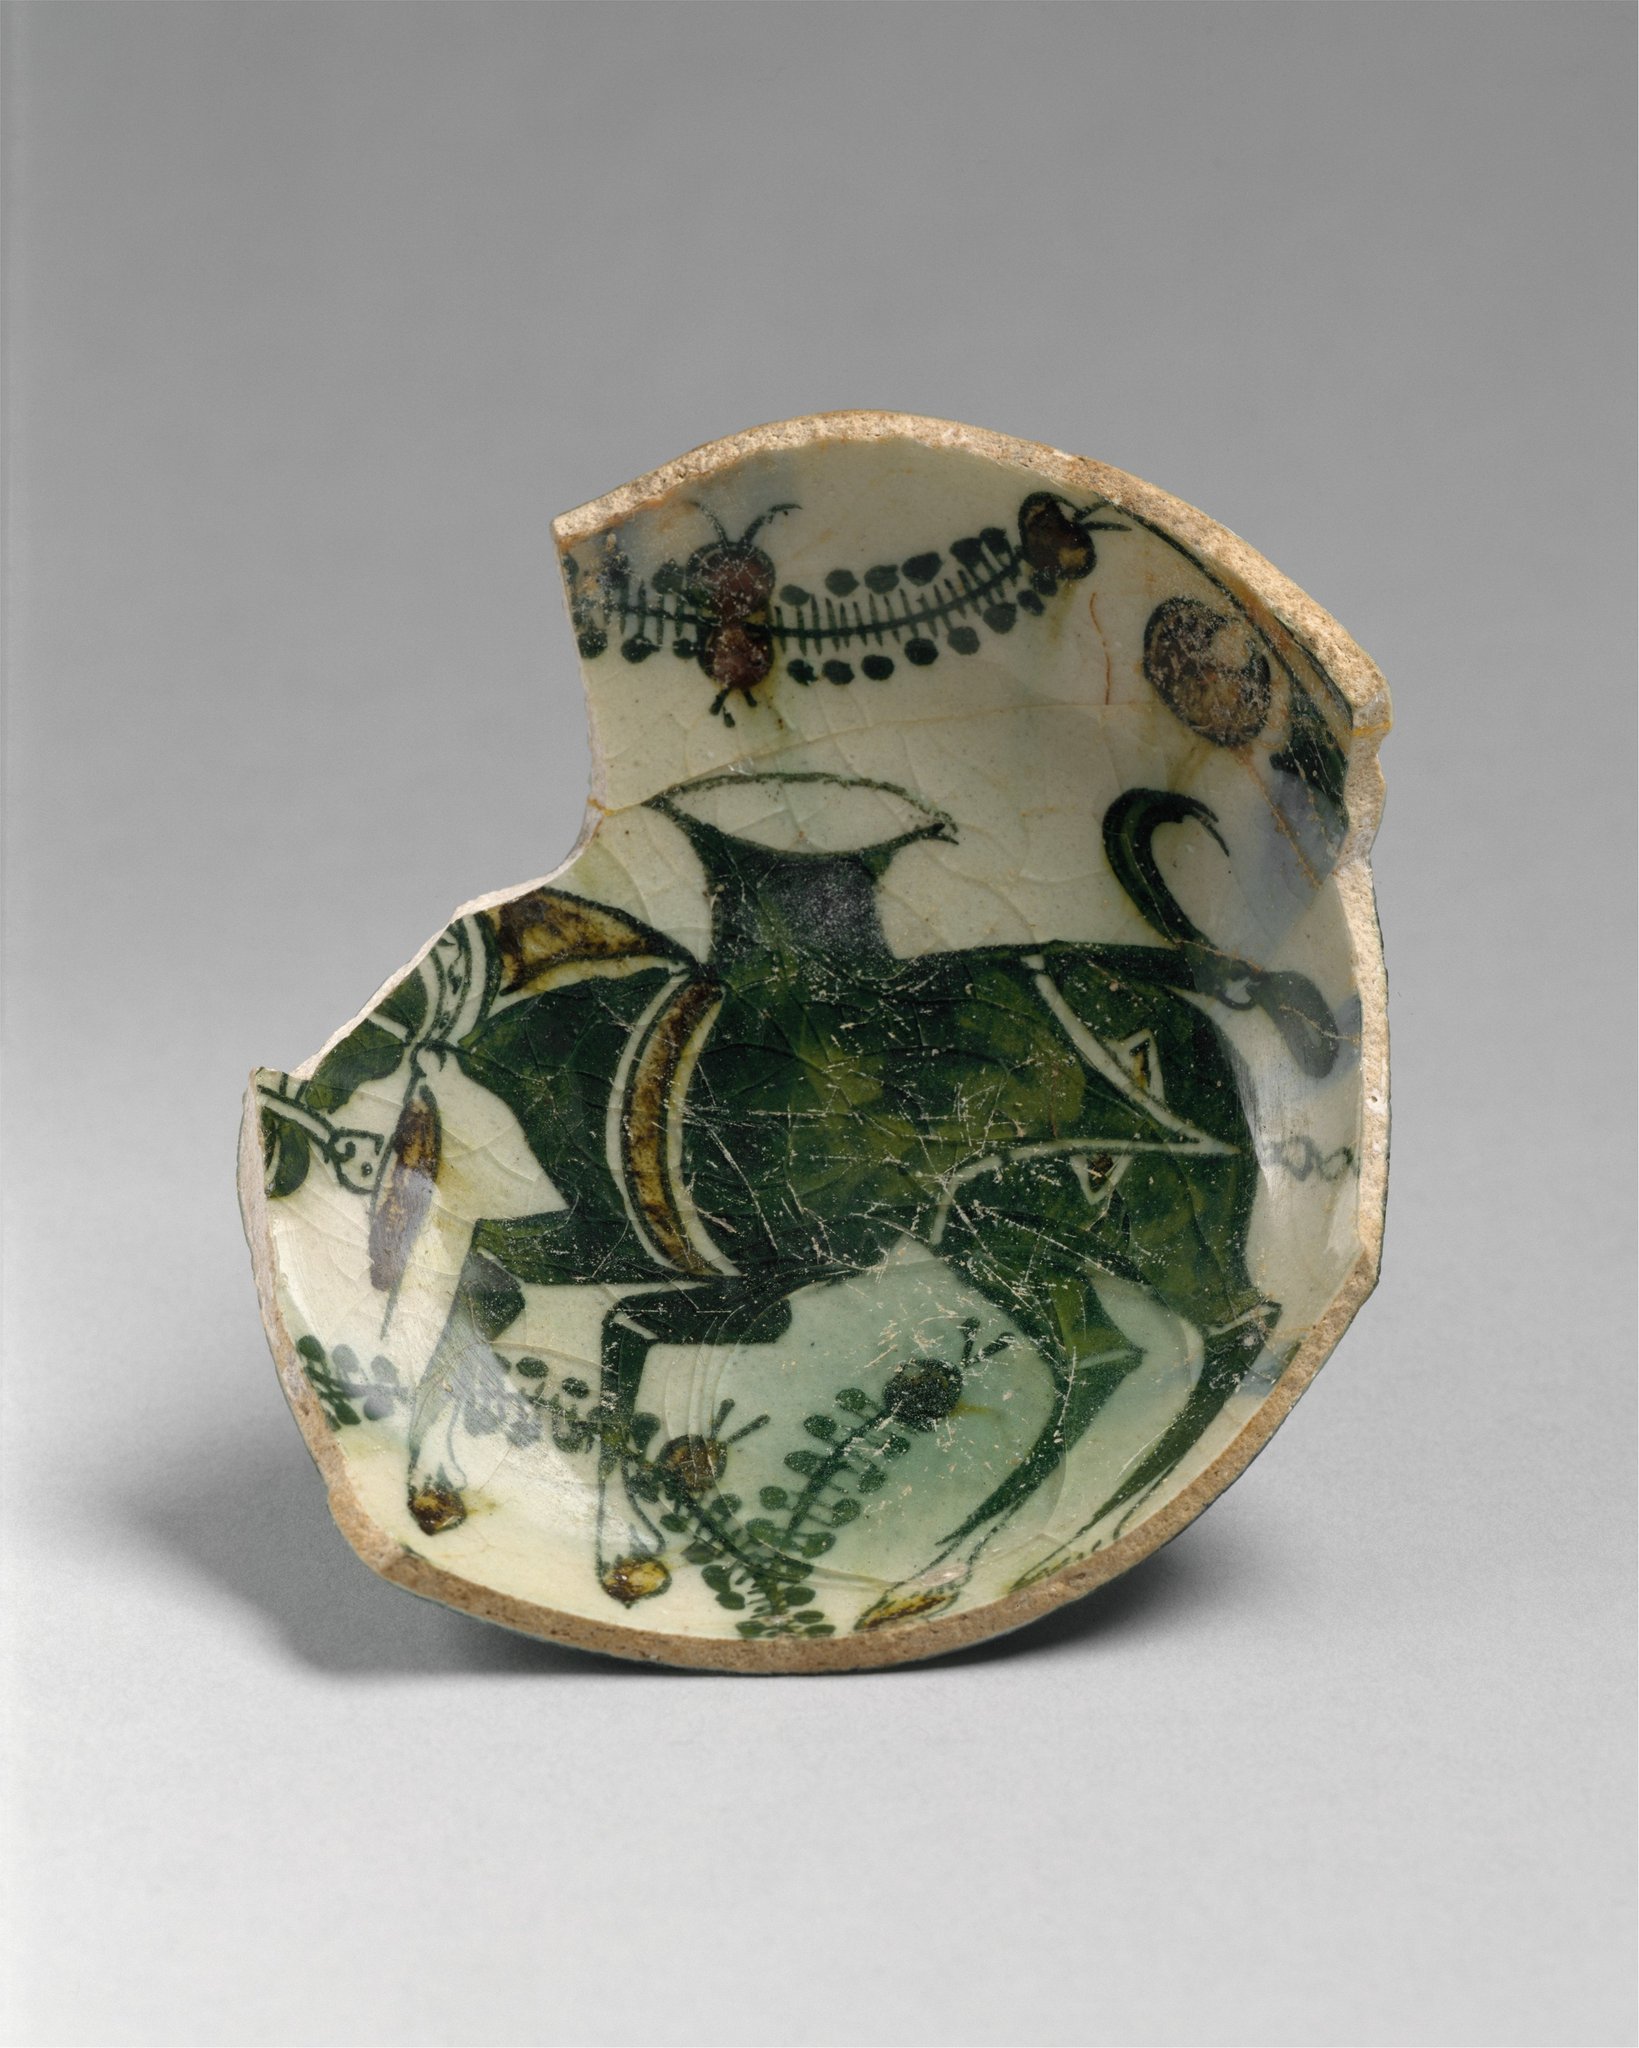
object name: fragment of a bowl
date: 1101-1300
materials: glaze, stonepaste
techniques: painting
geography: syria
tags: horses